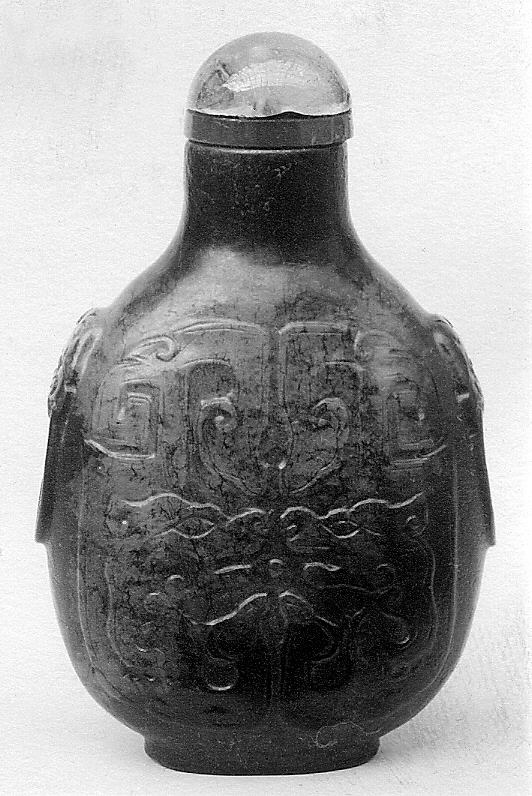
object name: snuff bottle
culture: chinese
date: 1736-1795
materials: gemstone, jade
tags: animals